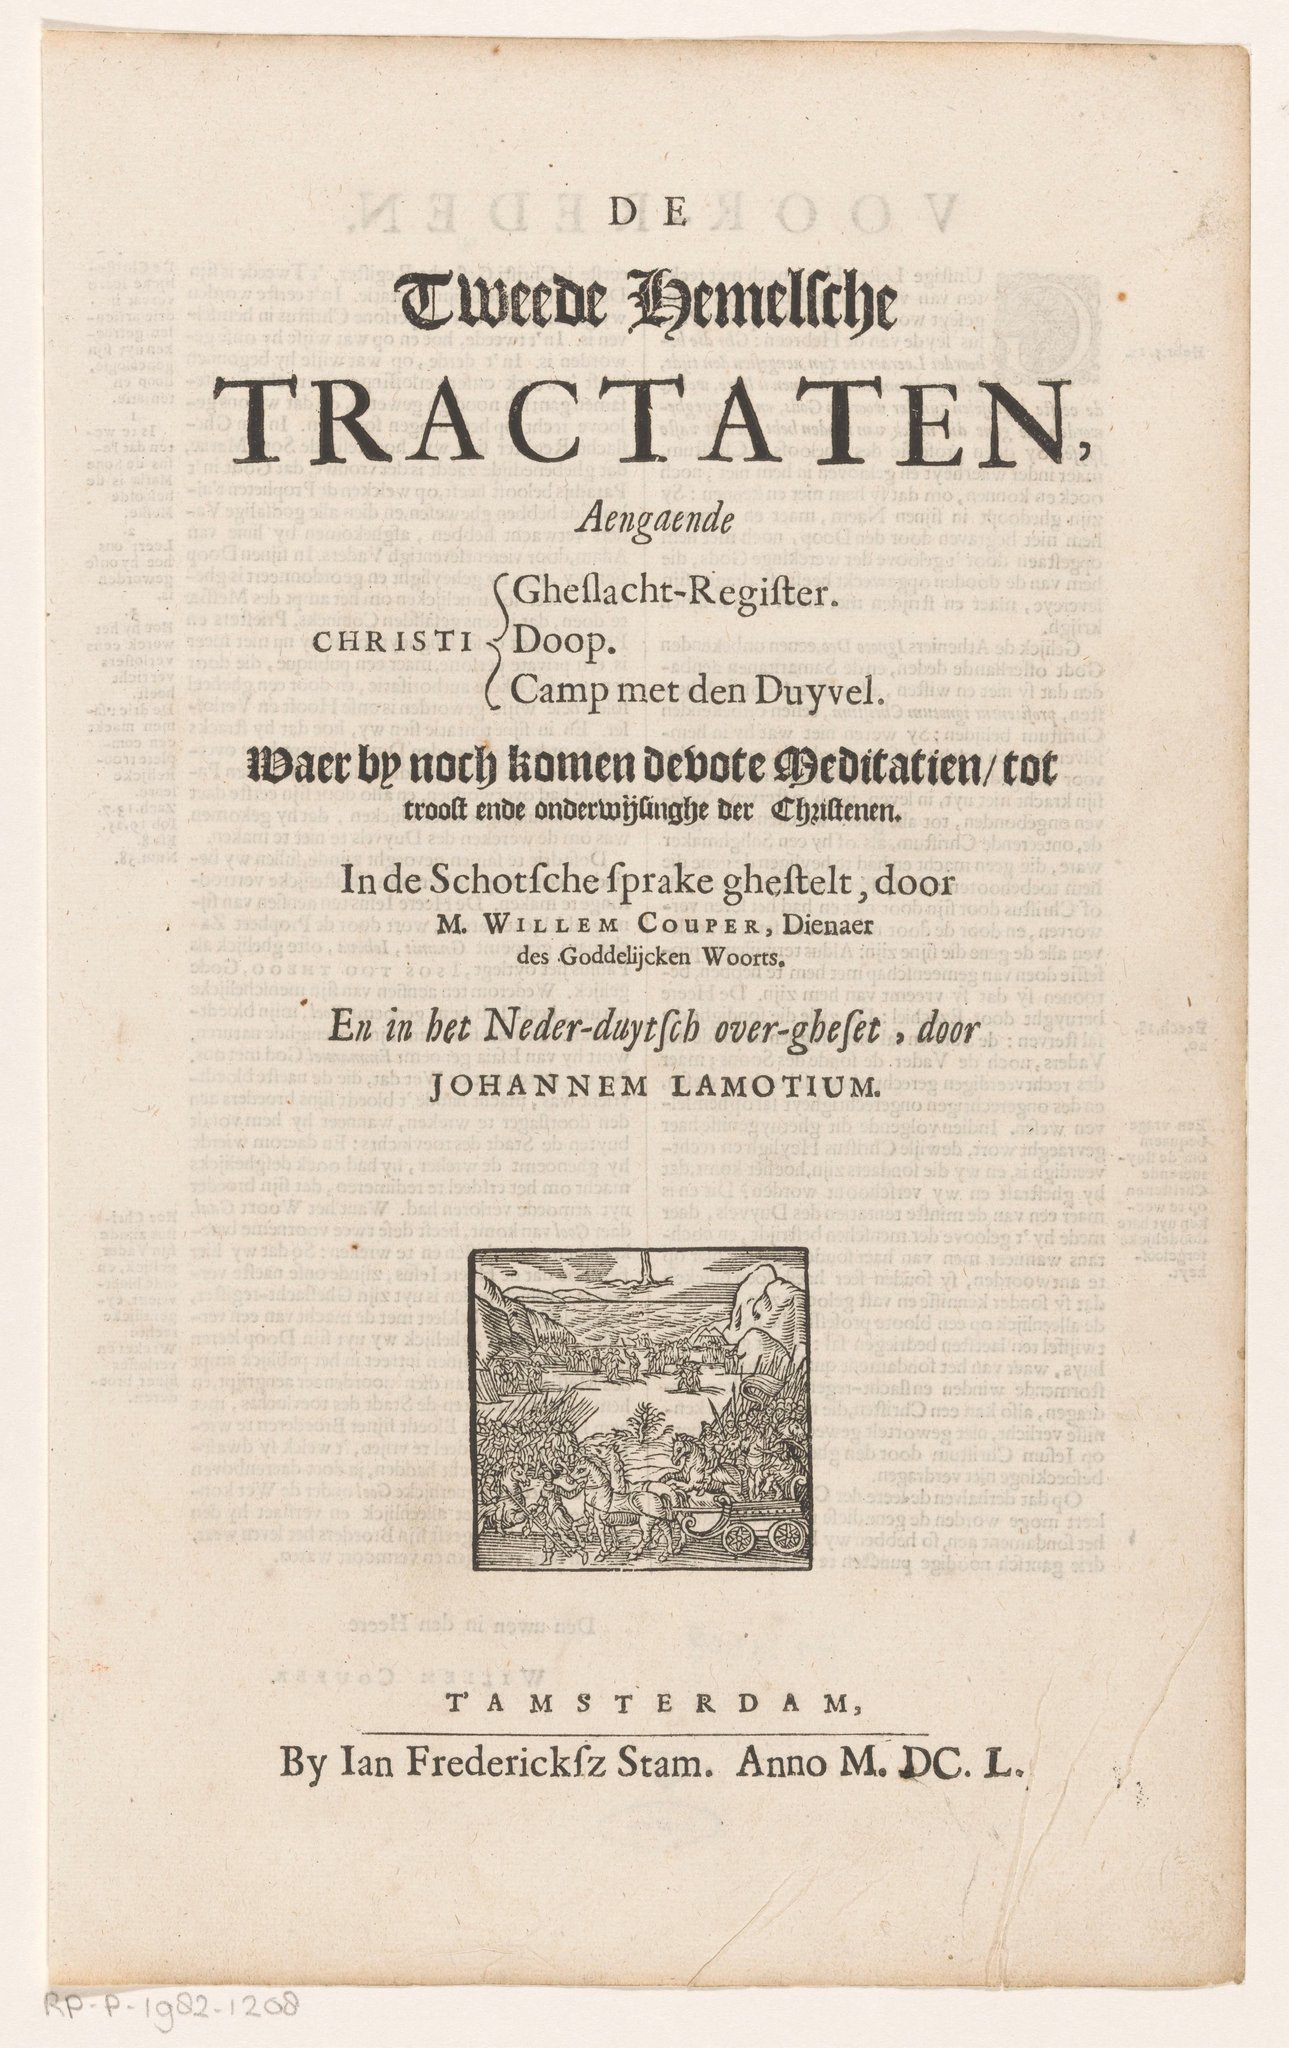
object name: titelblad, titelpagina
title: Veldslag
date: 1650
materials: paper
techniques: letterpress printing, engraving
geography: amsterdam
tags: battle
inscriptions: collector's mark: Lugt 2228, collector's mark: Lugt 2760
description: Titelpagina voor: Couper, William en Lamotius, Johannes. De Tweede Hemelsche Tractaten. AMsterdam: Stam, Jan Fredericksz, 1650.